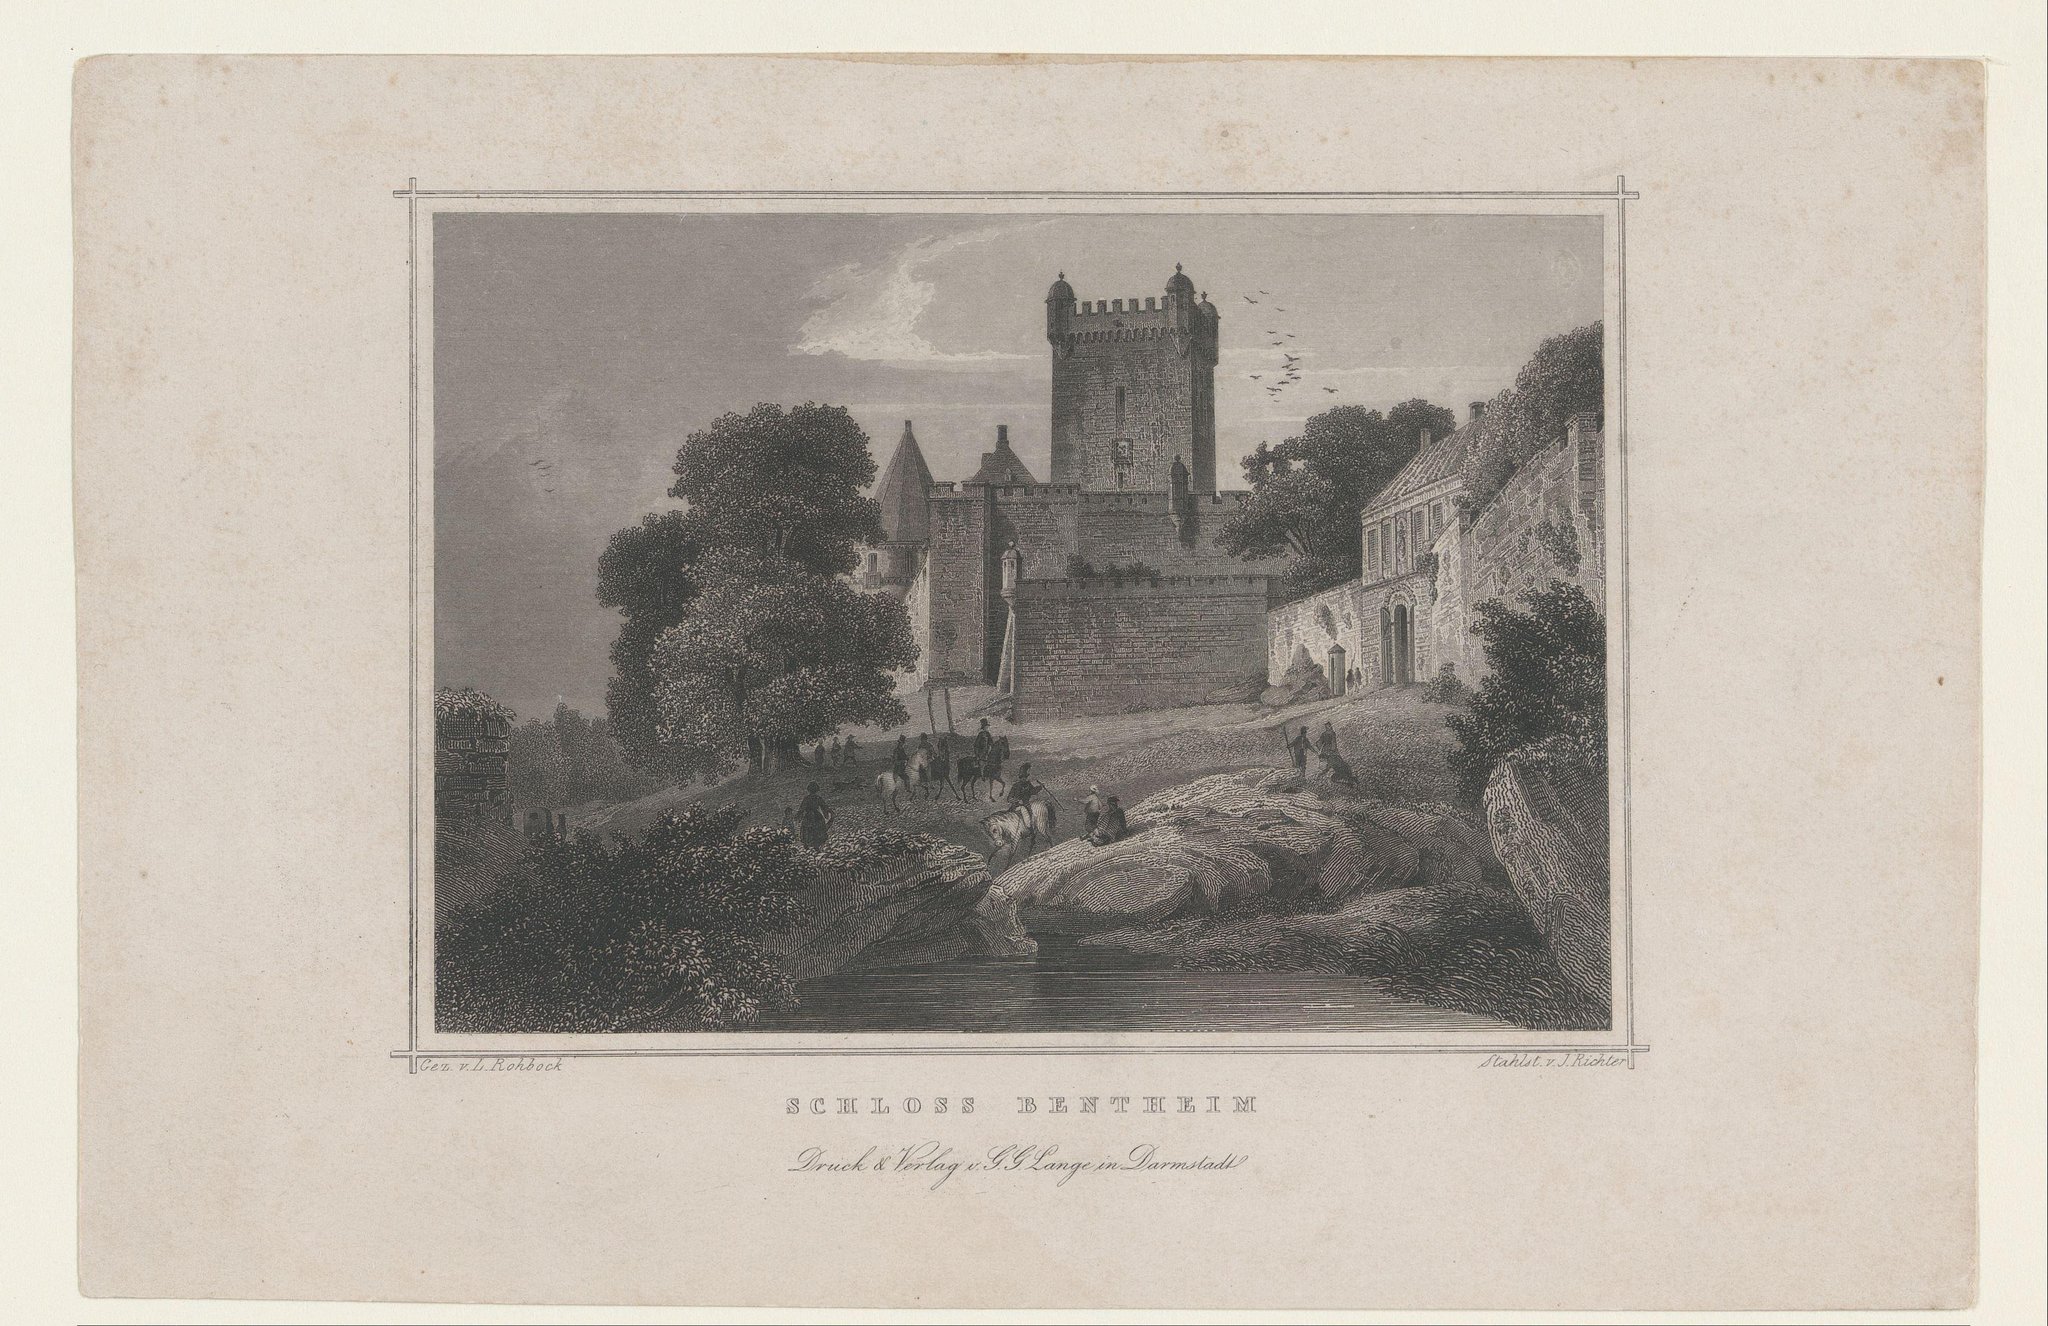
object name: print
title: Gezicht op Kasteel Bentheim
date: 1831-1843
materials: paper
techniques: engraving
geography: darmstadt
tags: castle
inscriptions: collector's mark: Lugt 2228